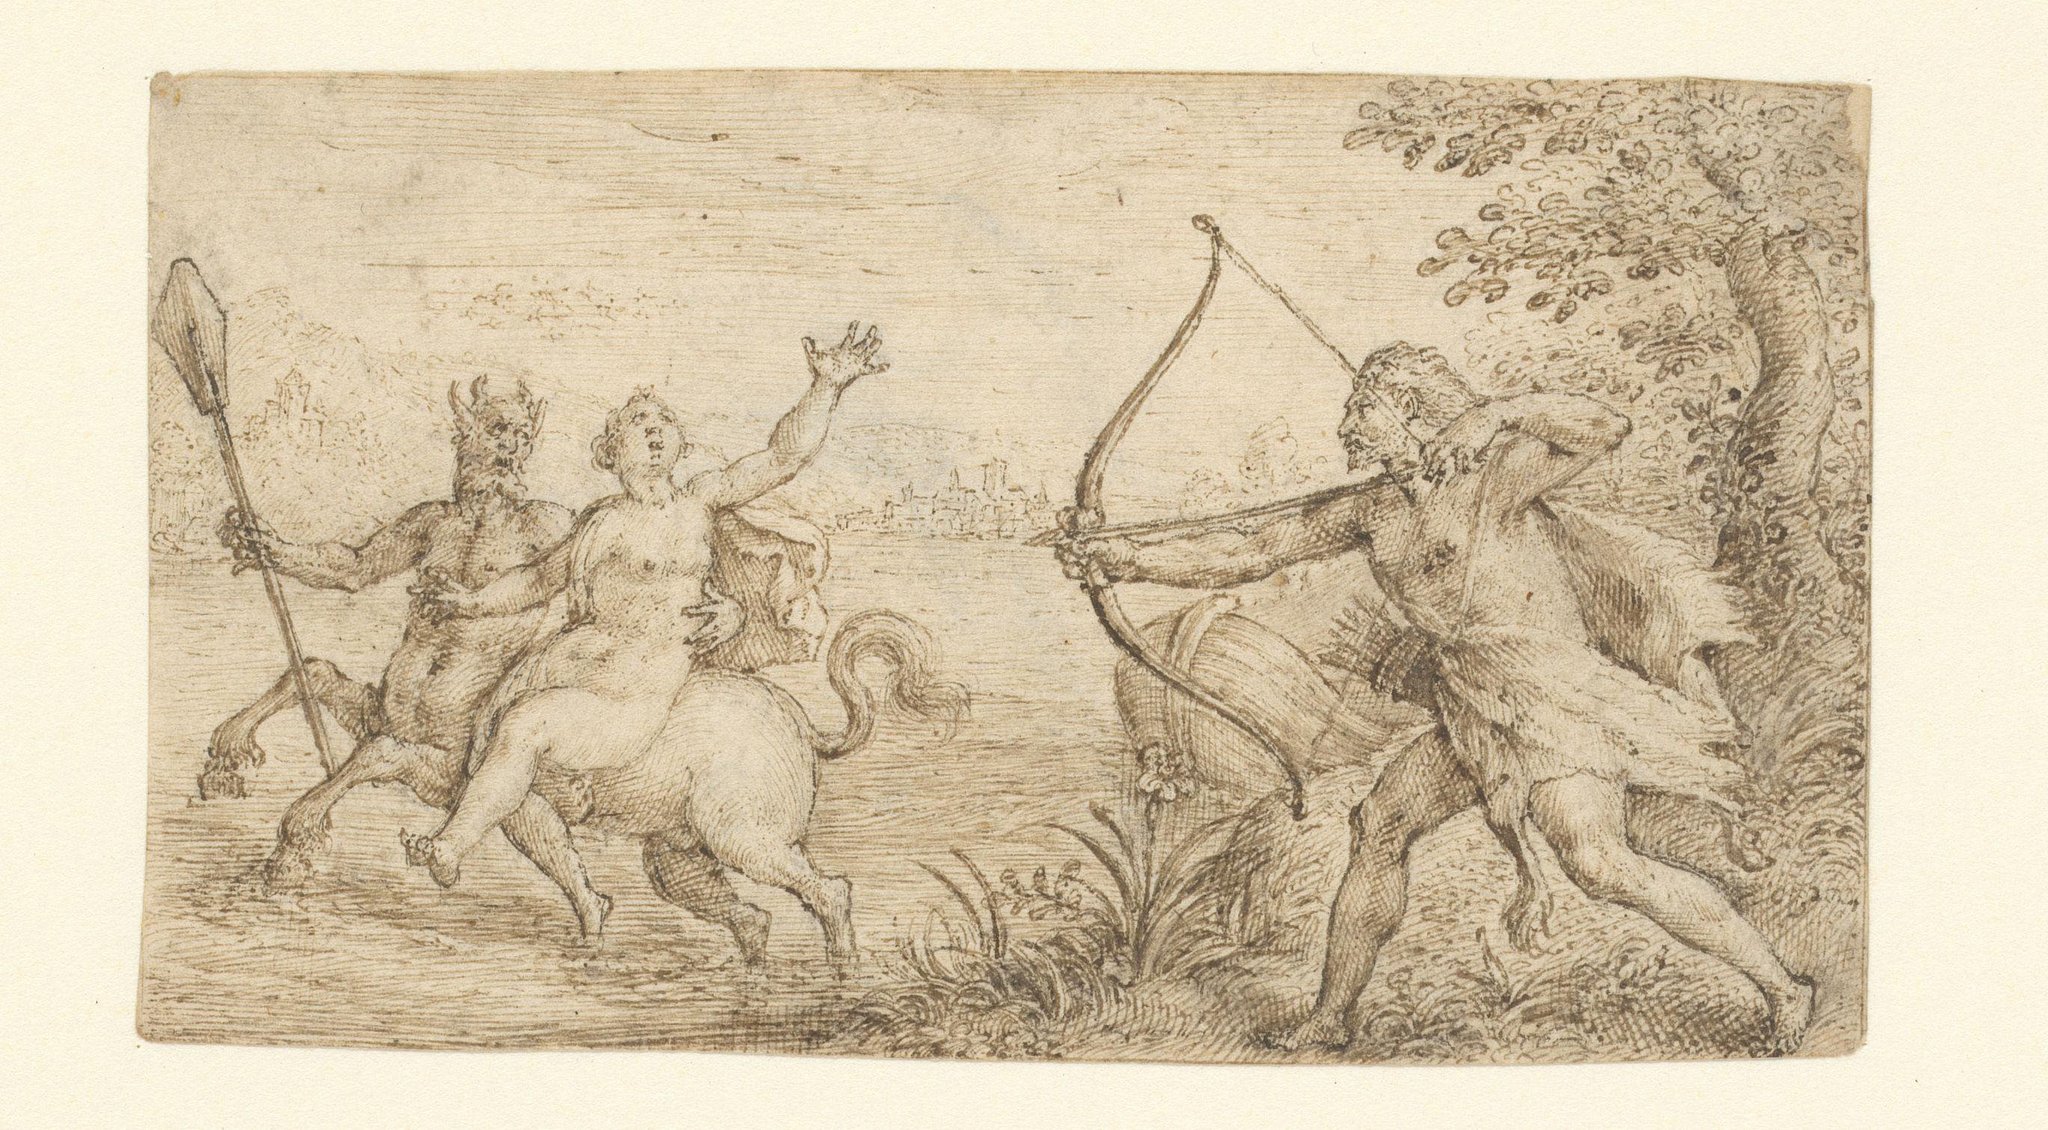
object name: design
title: Hercules richt zijn boog op de centaur Nessus die Deïanira ontvoert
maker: crispijn van de passe (i)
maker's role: draughtsman, print maker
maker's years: 1564-1637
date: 1575-1602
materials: ink, paper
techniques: pen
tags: hercules shoots nessus, the centaur, who attempts to carry off deianira